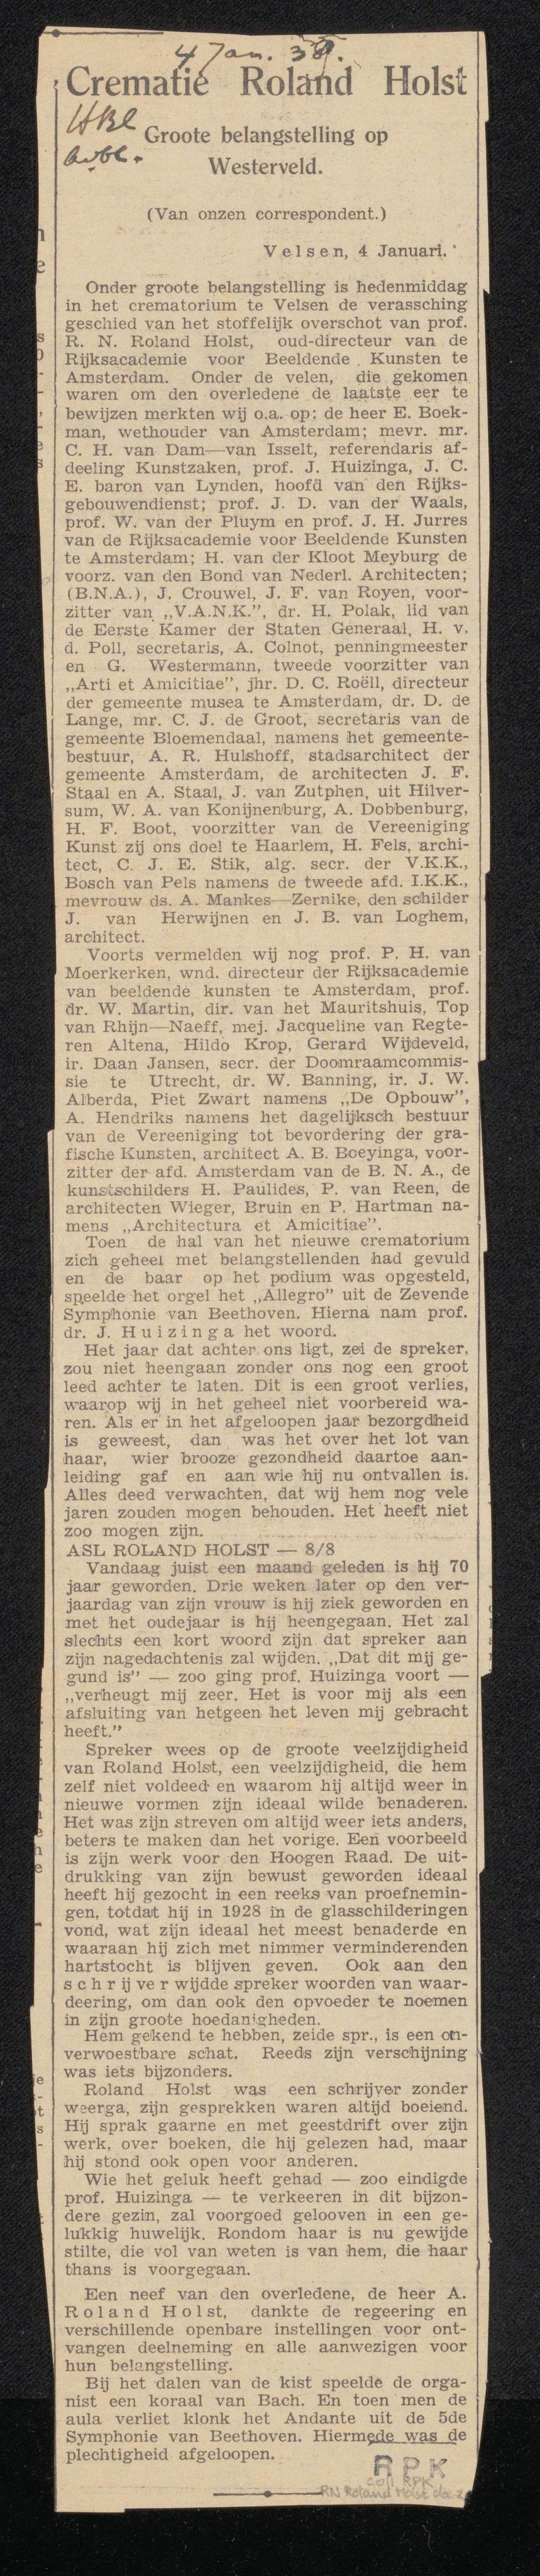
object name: newspaper clipping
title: Krantenknipsel betreffende Richard Roland Holst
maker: Anonymous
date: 1939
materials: paper, ink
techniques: printing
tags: richard nicolaüs roland holst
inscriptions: collector's mark: ‘RPK’